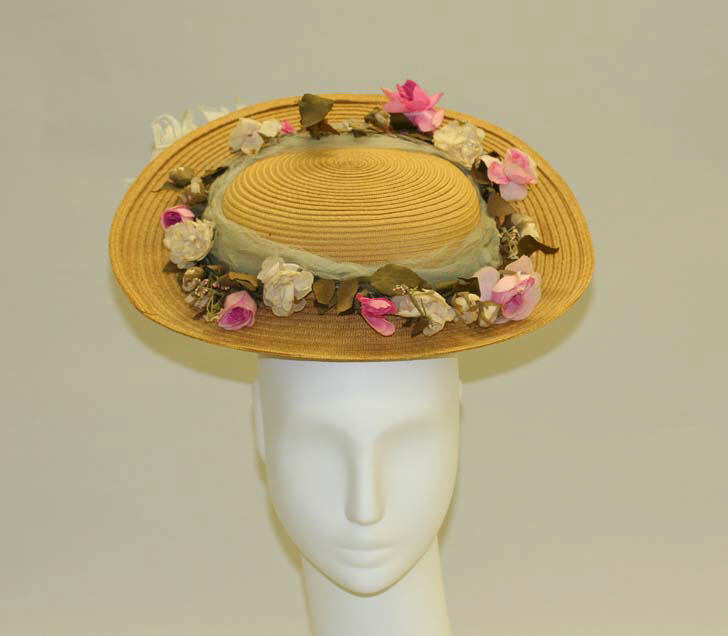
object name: hat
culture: american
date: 1892-1895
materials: feather, silk, fiber